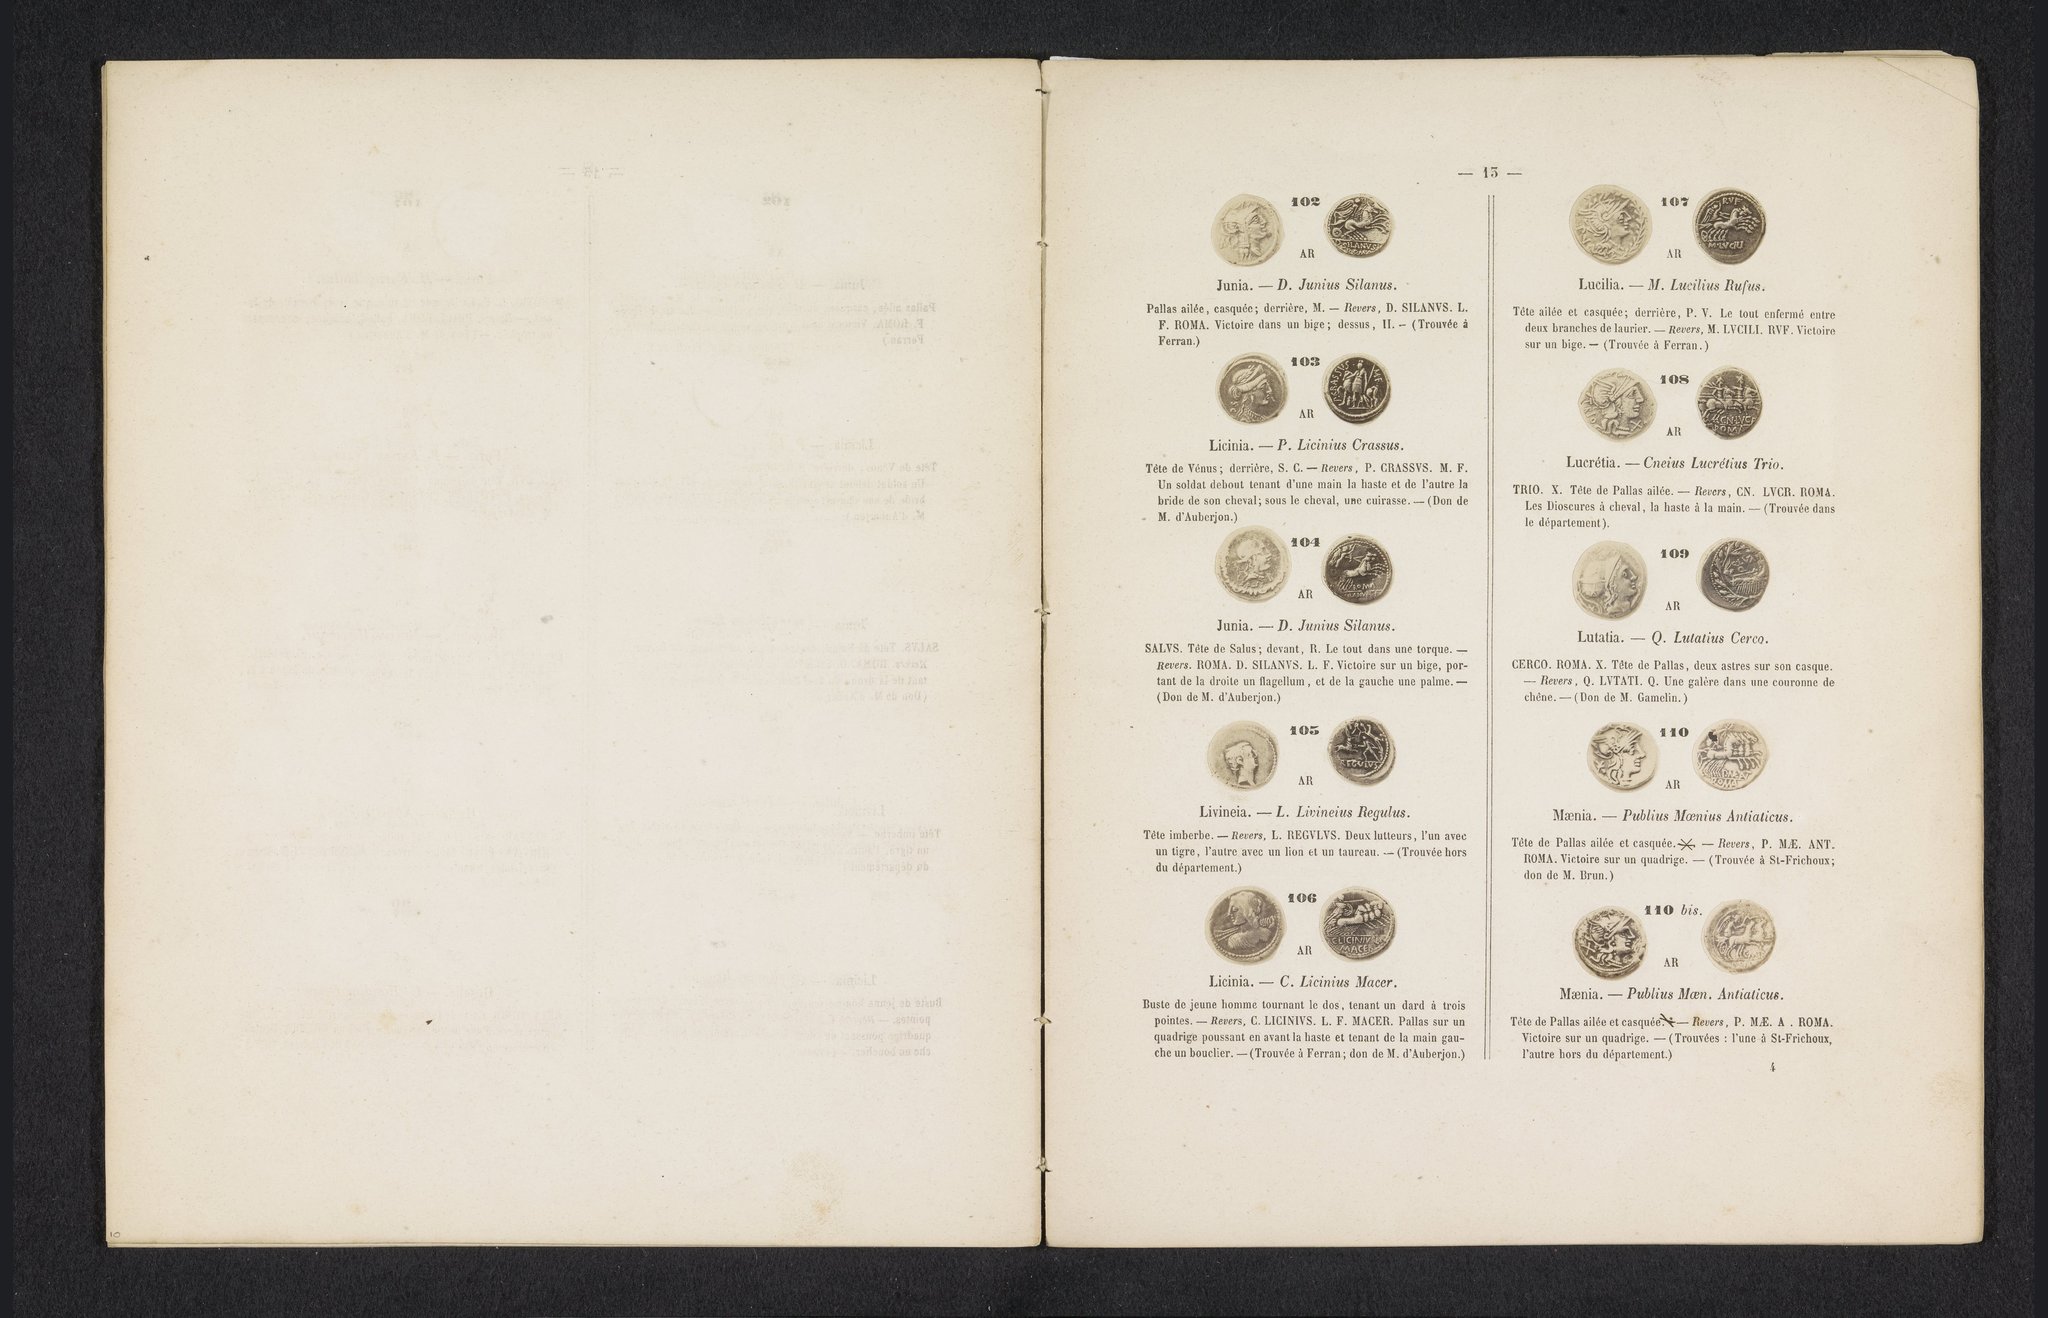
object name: photograph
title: Tien Romeinse munten, gezien van voor- en achterkant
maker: léopold verguet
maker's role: abt, fotograaf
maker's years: 1817-1914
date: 1854-1864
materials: photographic support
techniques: albumen print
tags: coin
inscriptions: number